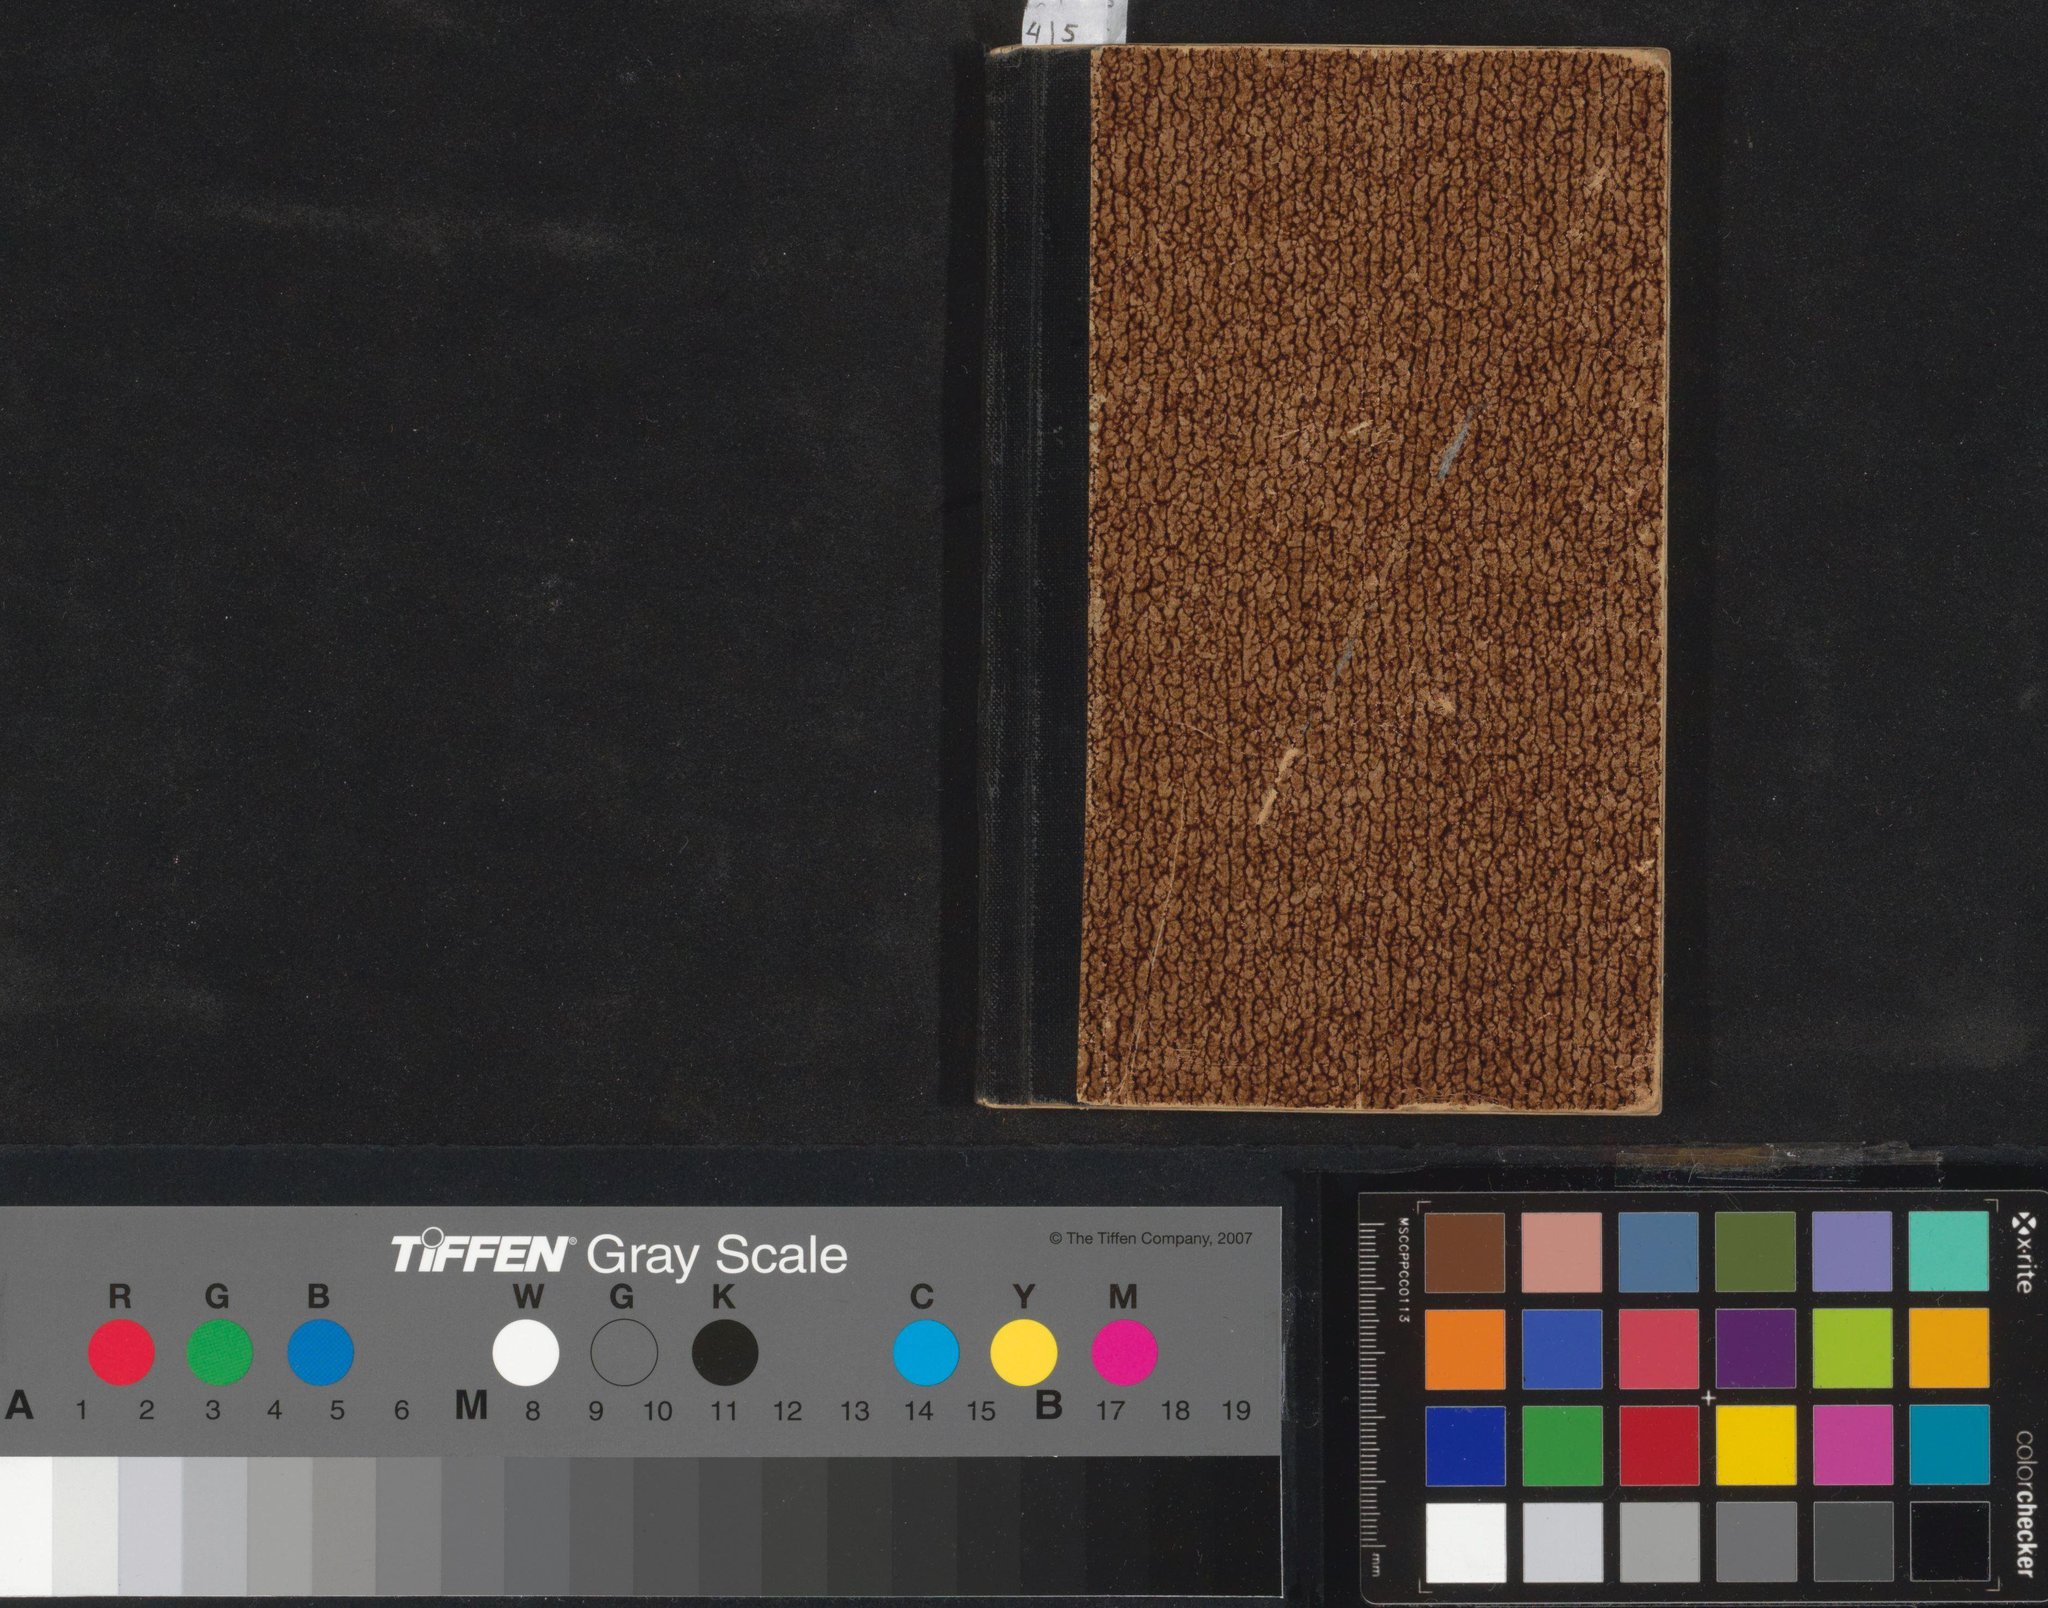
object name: sketchbook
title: Schetsboek met 33 bladen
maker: reijer stolk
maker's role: draughtsman, print maker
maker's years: 1896-1945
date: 1908-1919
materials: cardboard, ink, linen, paper, pencil, watercolor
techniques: brush, pen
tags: ornaments ~ art, anatomy (non-medical), interior of the house, printed matter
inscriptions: date: ‘mijn vacantie-dagen van 8-22 Augustus/ 1919.’, retailer's mark: ‘H.J.T. MATVELD/ KANTOORHANDEL/ PAPIERHANDEL/ WAGENSTR. 127 ZOUTMANSTR. 56’, annotation: ‘te H[...]ghuizen te Huizen en/ [...] te Nunspeet/ [...]’, collector's mark: Lugt 2228a, annotation: ‘Hoogwater/ [...]/ Nieuwe[...]/ [...]93 ca [...]/ 3008/ HS/Ba[...]s/ R[...]brug’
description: Schetsboek bestaande uit 33 bladen met figuren, stillevens, interieurs, landschappen, ornamenten en reclameontwerpen voor zonneschermen.